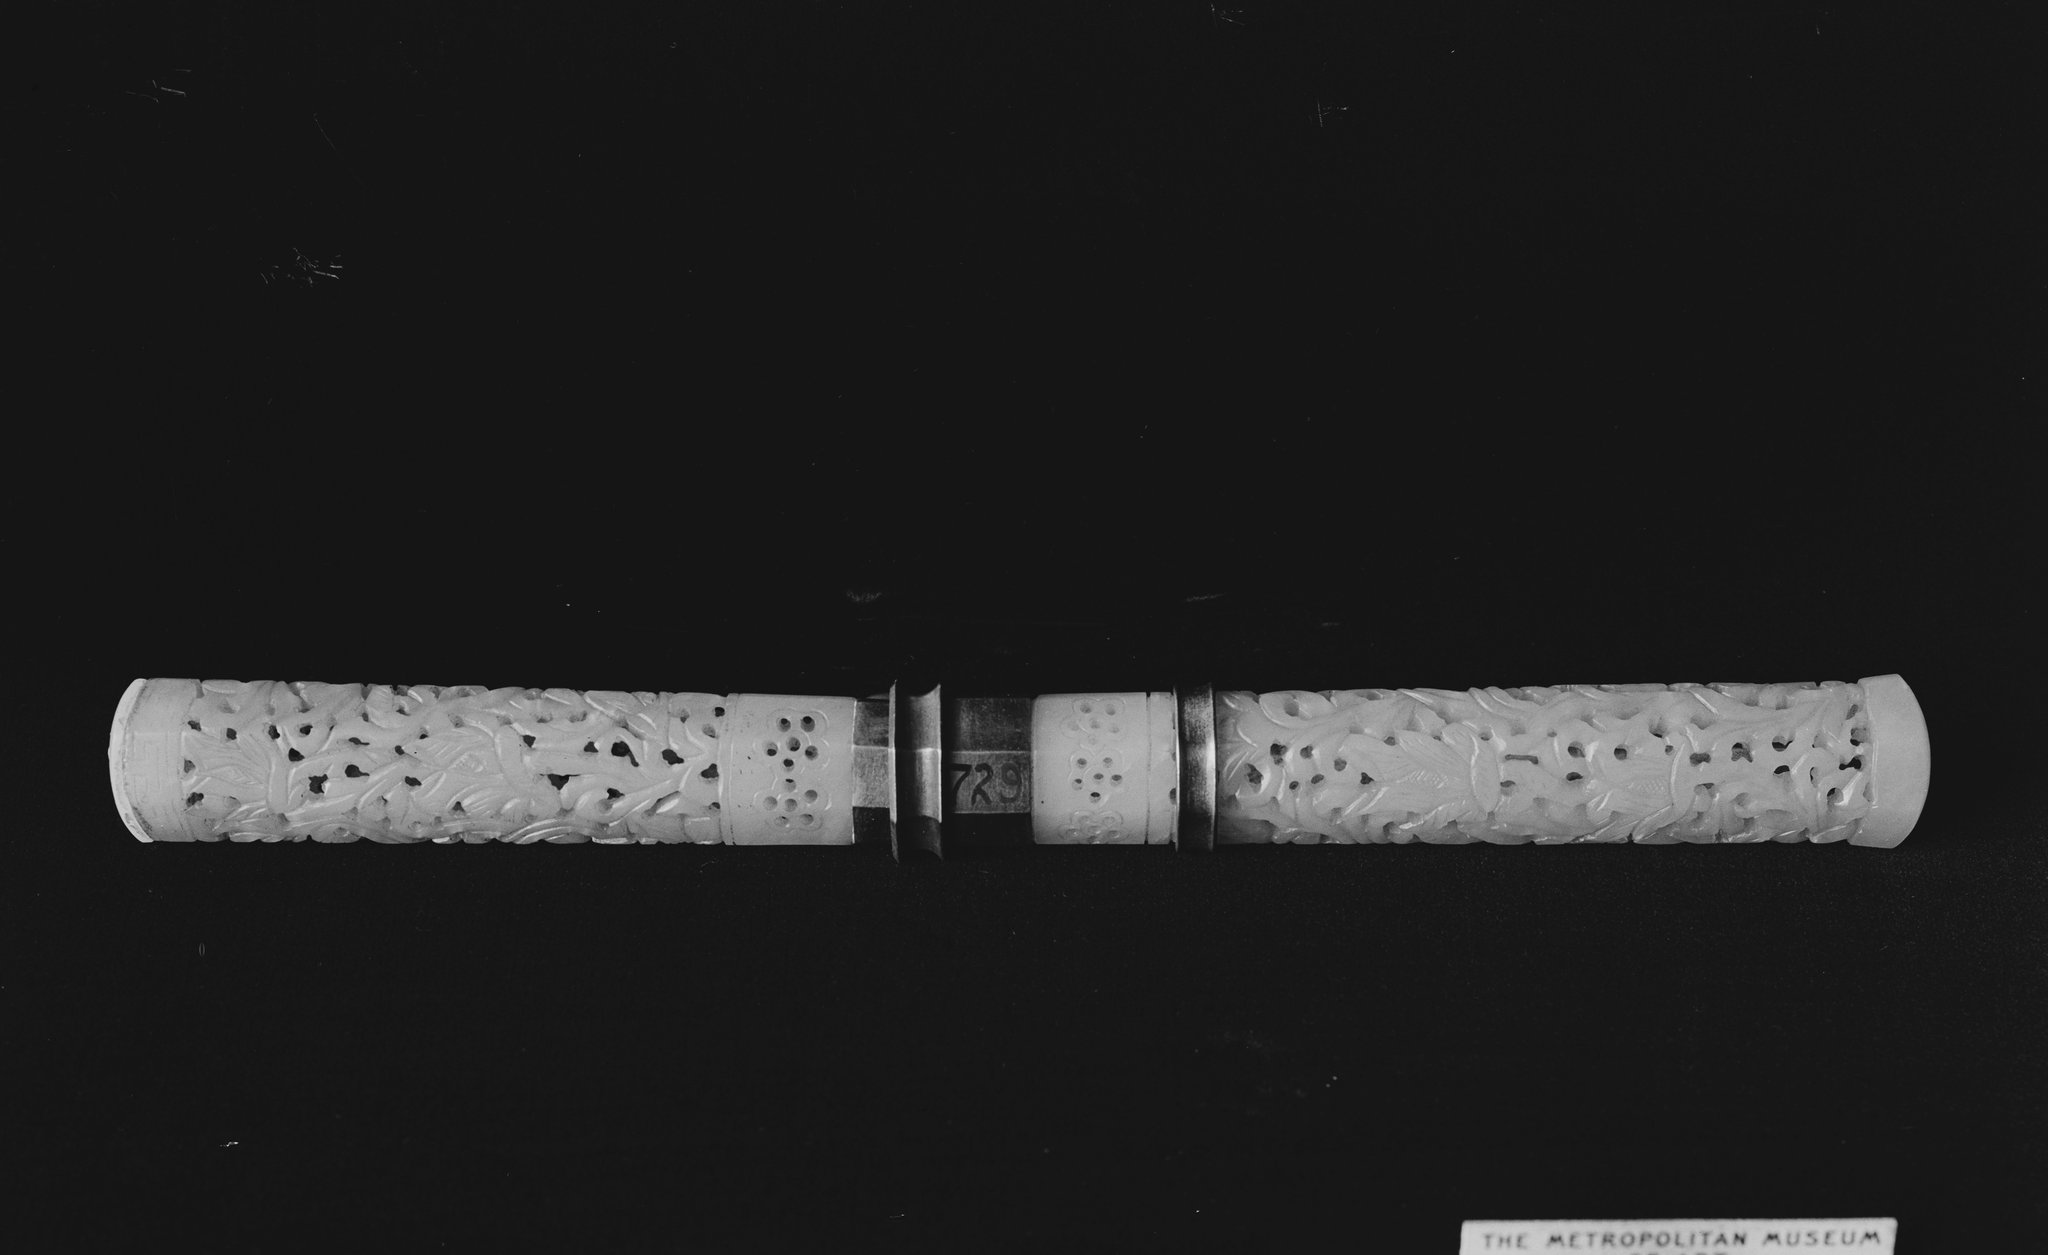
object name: knife with sheath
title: Sheath Knife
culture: chinese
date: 1796-1875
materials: jade